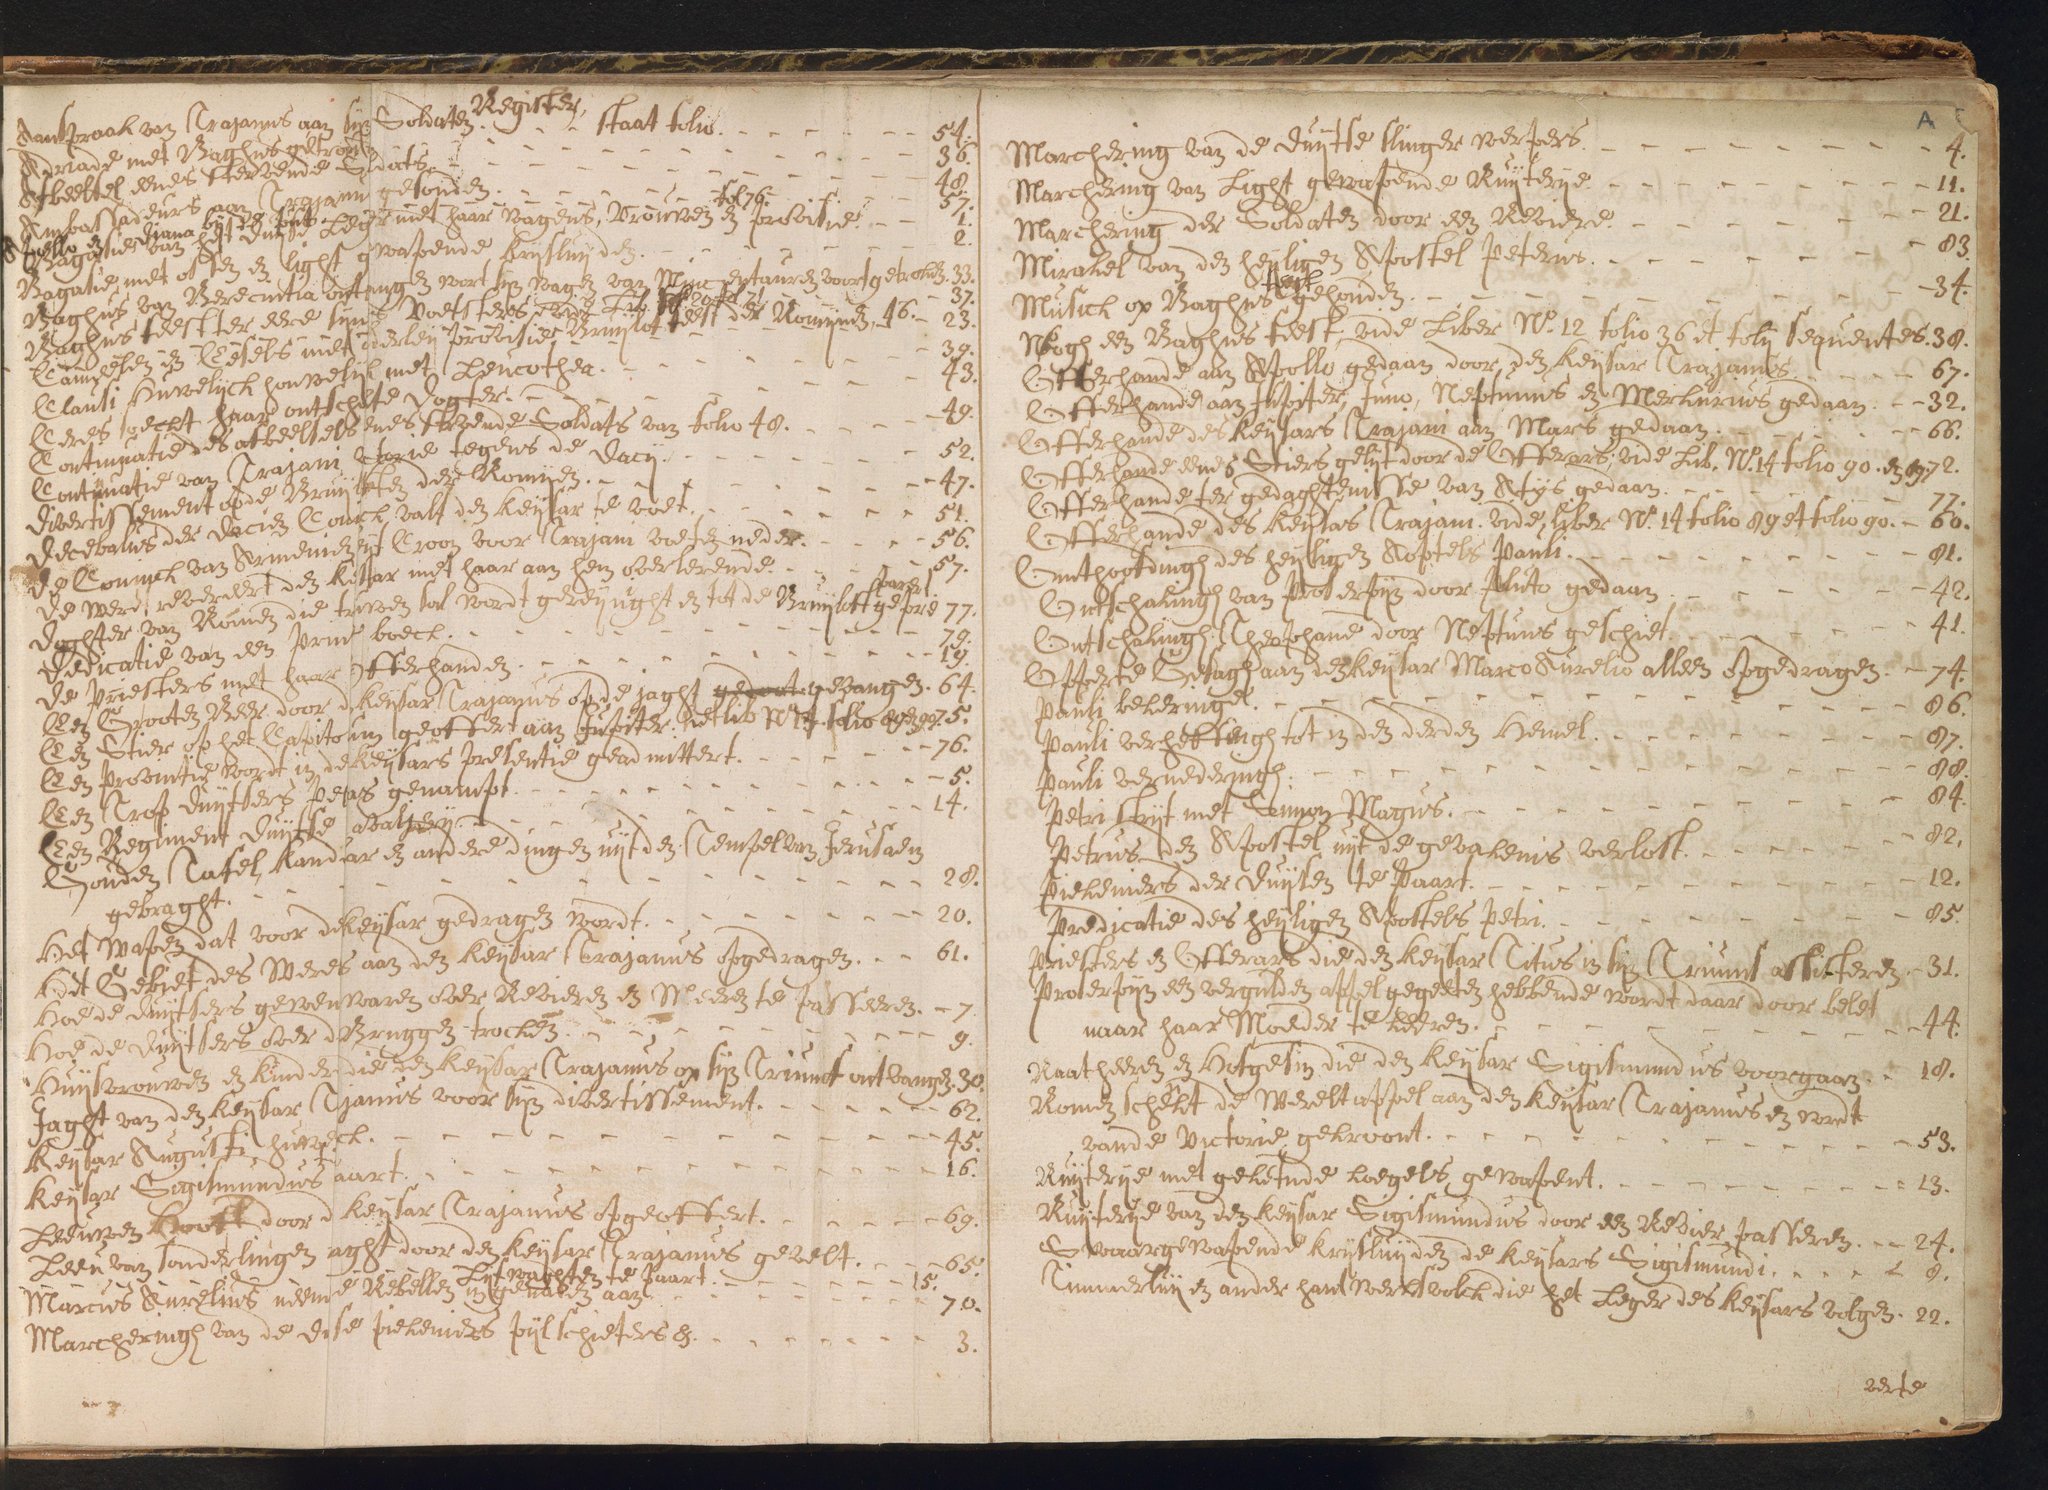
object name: manuscript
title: Handgeschreven inventaris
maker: michiel hinloopen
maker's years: 1619-1708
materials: paper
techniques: pen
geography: amsterdam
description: Inventaris maakt deel uit van een album.